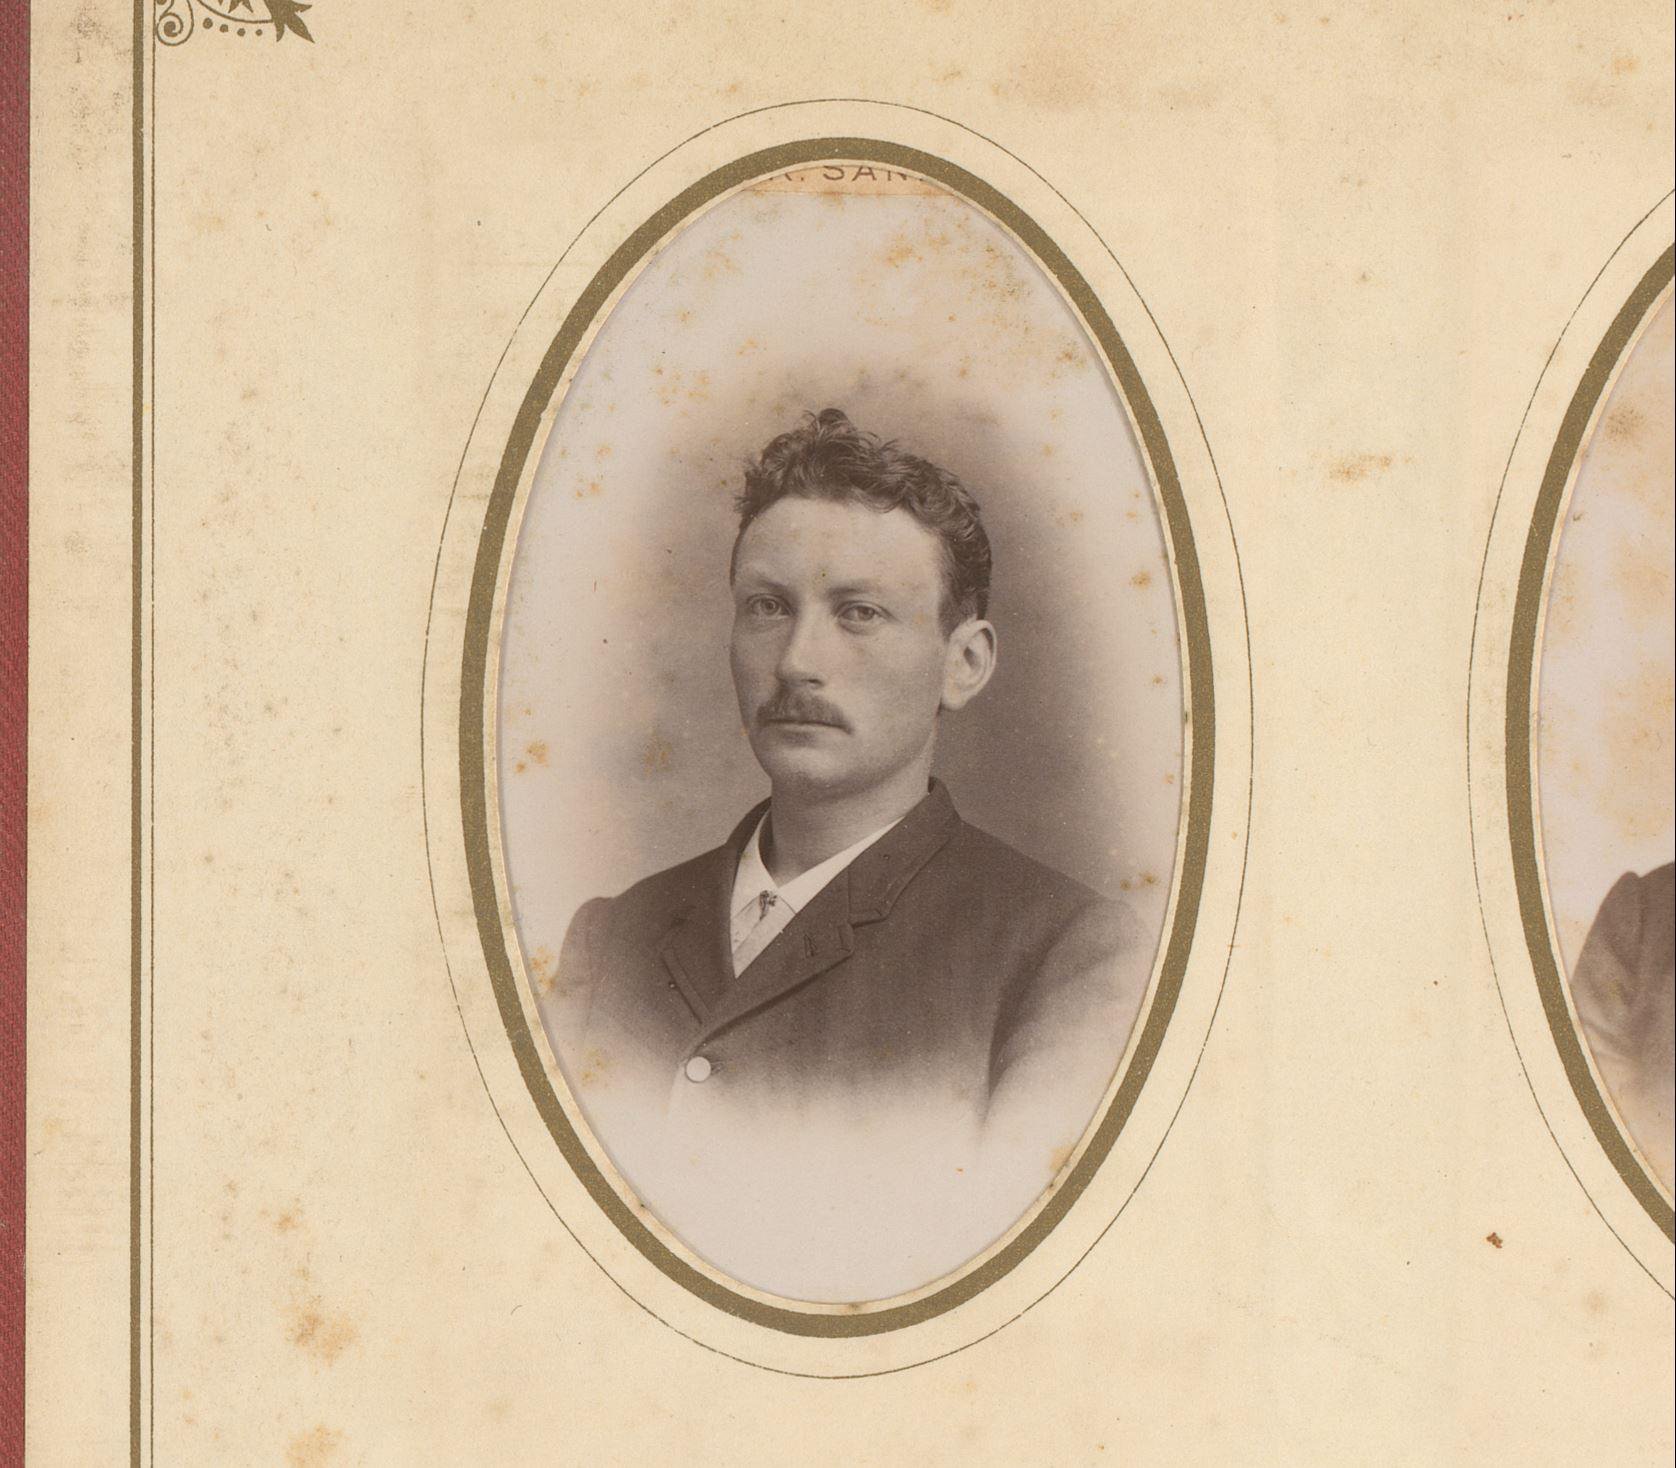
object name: photograph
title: Portret van een man met snor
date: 1860-1900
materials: cardboard, photographic support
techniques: albumen print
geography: groningen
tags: moustache, historical persons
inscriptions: inscription: ‘Gebr. Sanders/ Photographie Instantanée/ Hoek Stoeldraaierstraat H.13,/ 2 de huis Kromme Elleboog/ Groningen/ Specialiteit in vergrootingen, de negativen/ blyven ter nabestelling bewaard.’